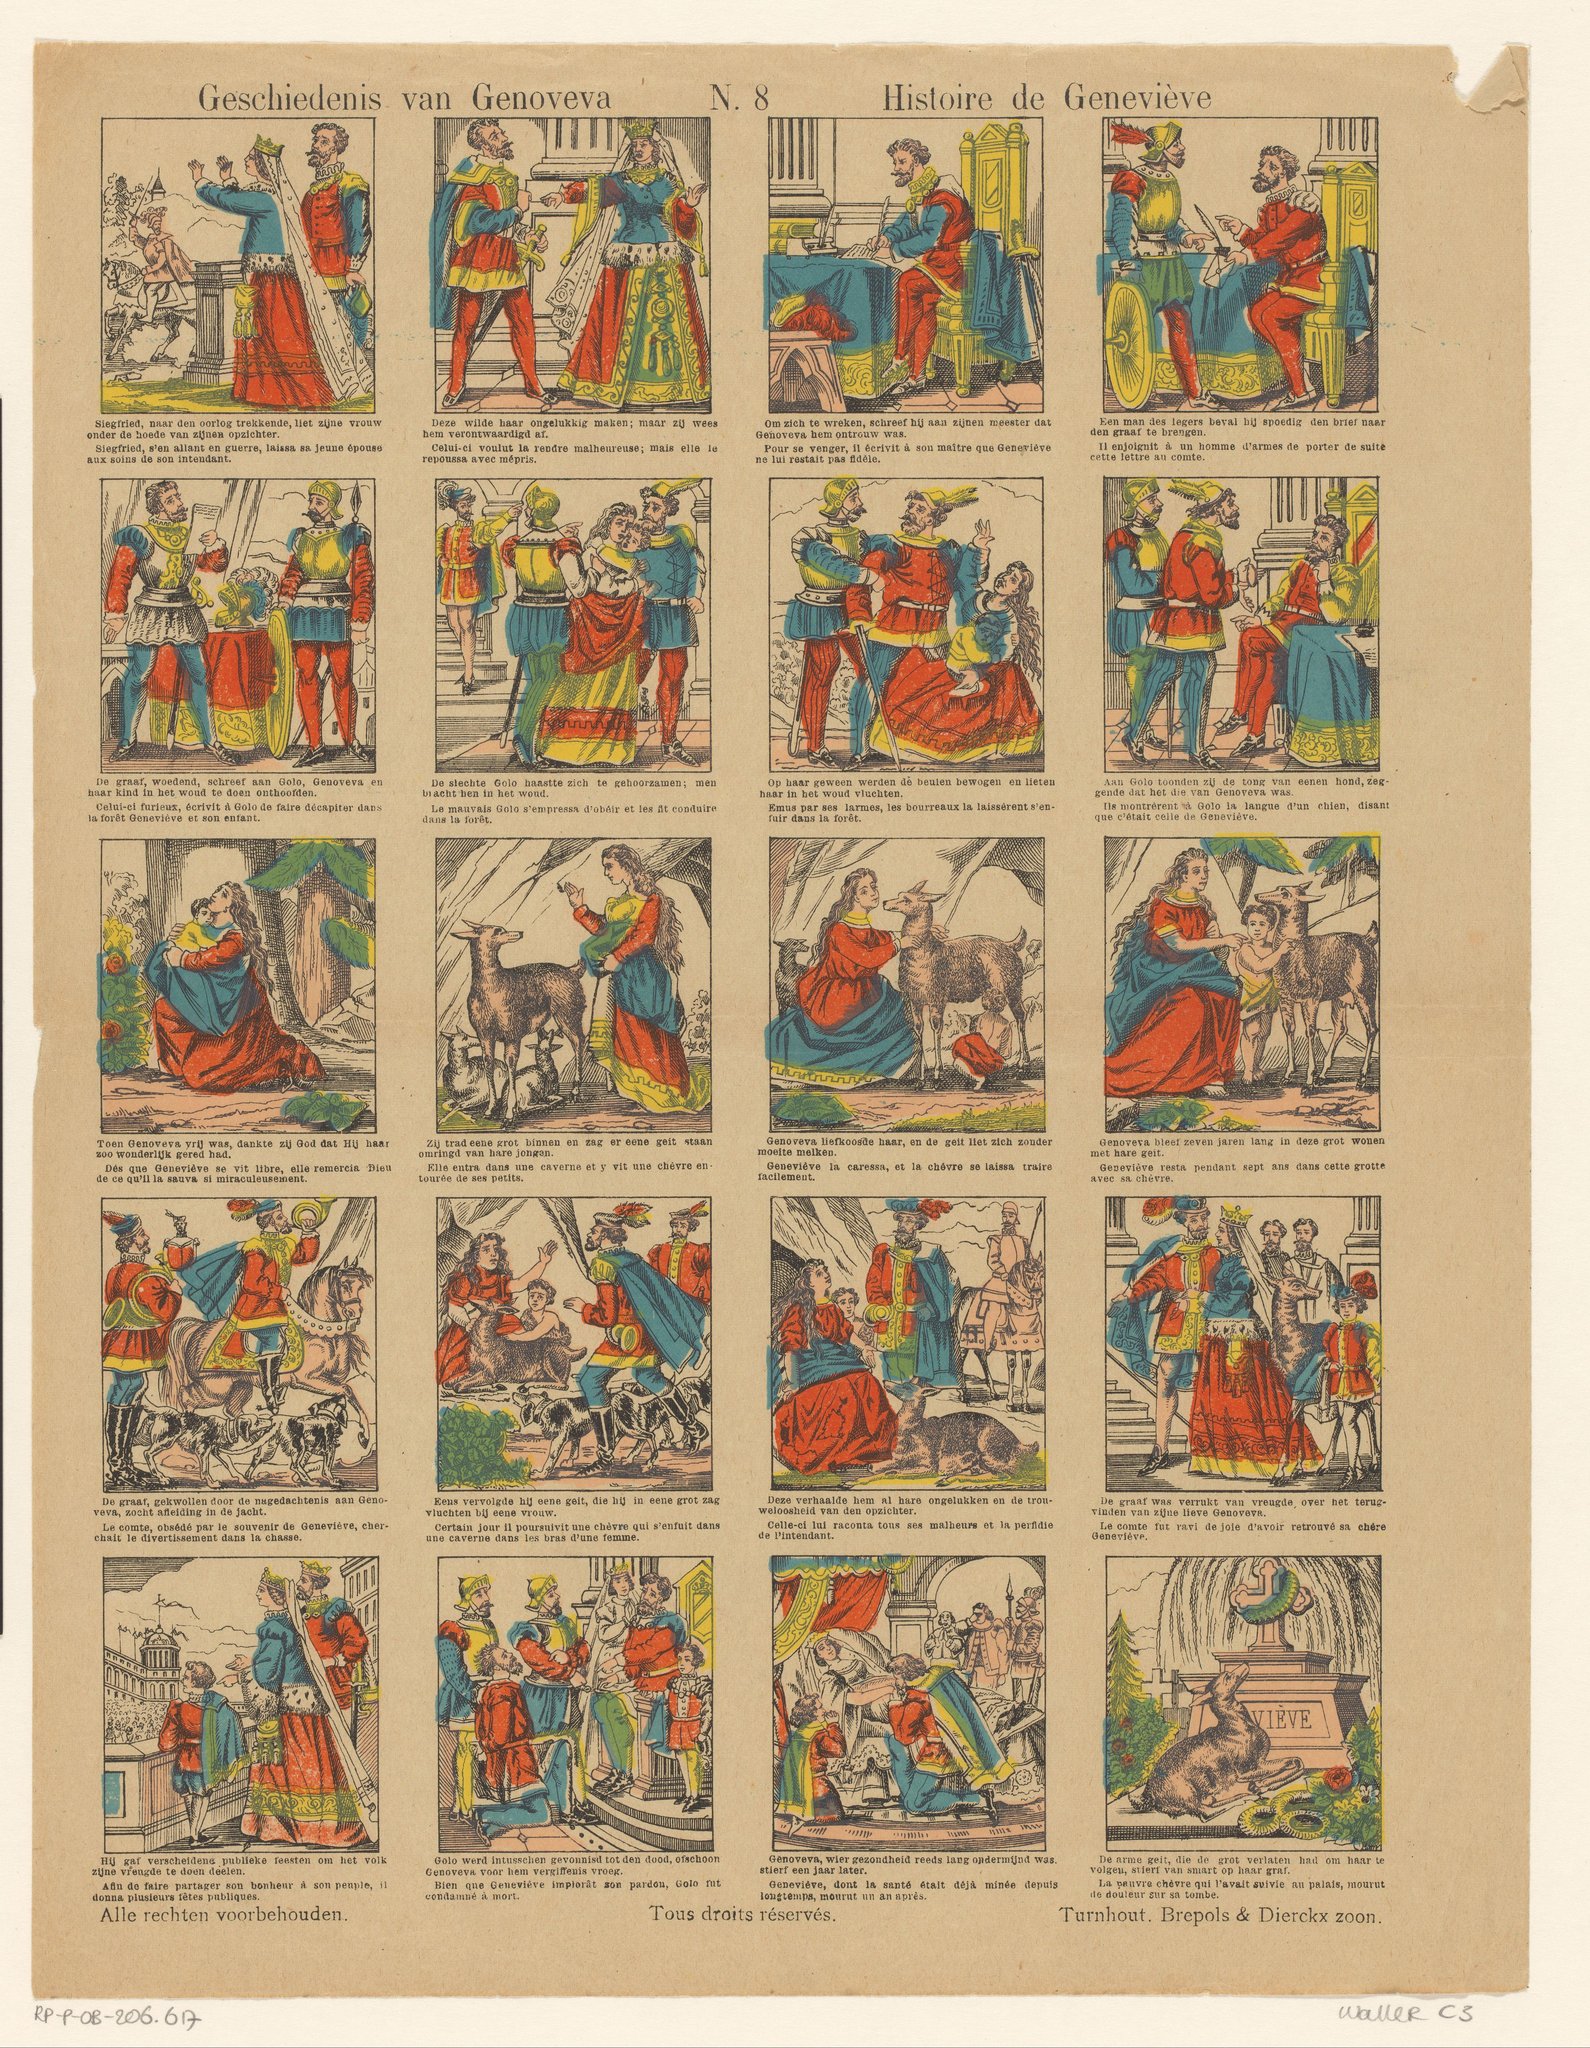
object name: popular print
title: Geschiedenis van Genoveva / Histoire de Geneviève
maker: Anonymous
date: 1833-1911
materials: paper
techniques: lithograph, letterpress printing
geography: turnhout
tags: genoveva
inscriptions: octrooivermelding, gedrukt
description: Blad met 20 voorstellingen over het leven van Genoveva van Brabant. Onder elke afbeelding een onderschrift in het Nederlands en in het Frans. Genummerd midden boven: N. 8.